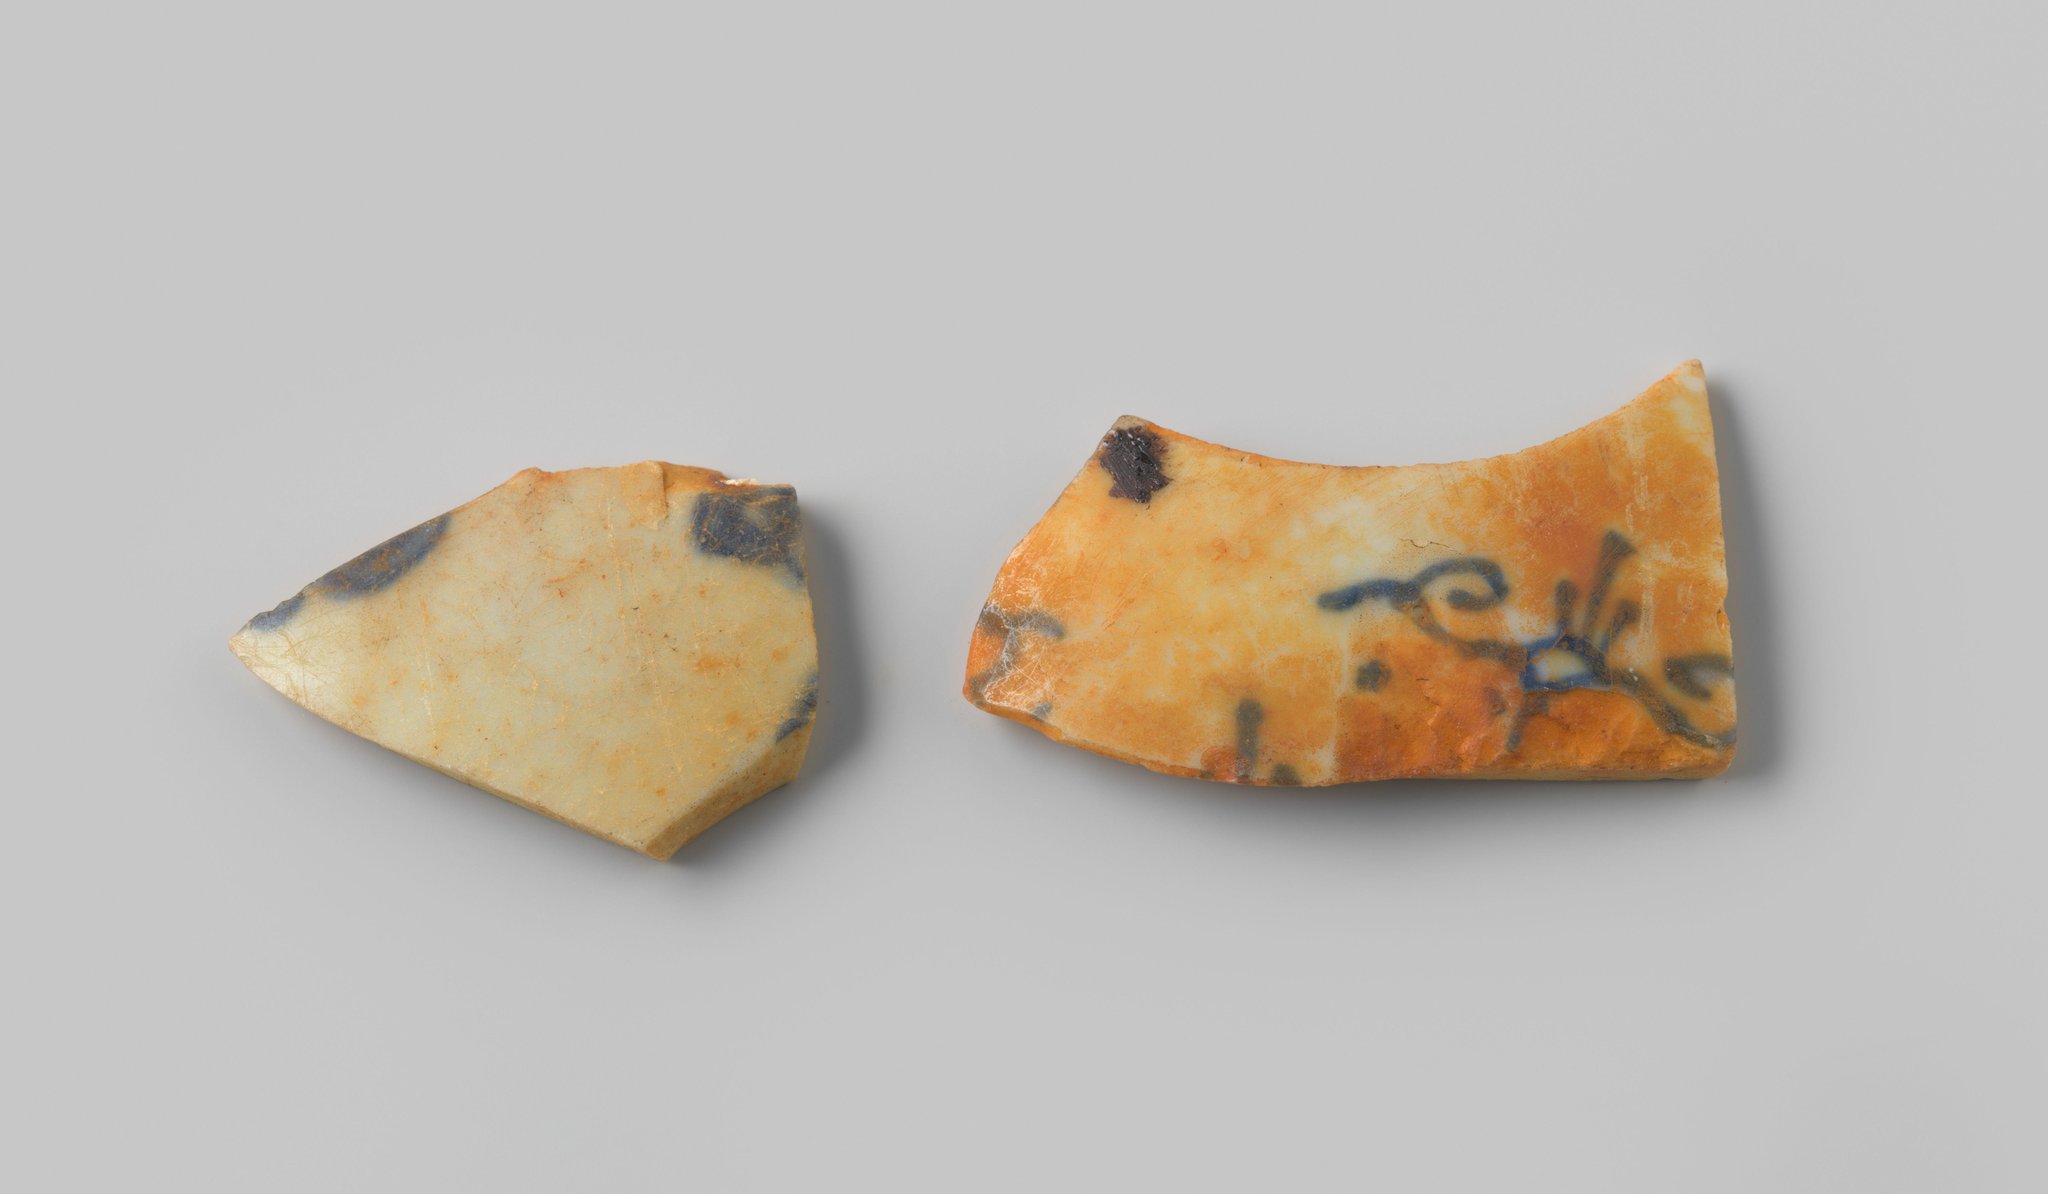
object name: sherd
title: Scherven van een kom uit het wrak van de Oost-Indiëvaarder Hollandia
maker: Anonymous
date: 1700-1743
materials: porcelain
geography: netherlands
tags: verenigde oostindische compagnie, hollandia (schip), annet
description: Porcelain, bowl, type 1; fragm of body, sim. NG 1980-27H824.